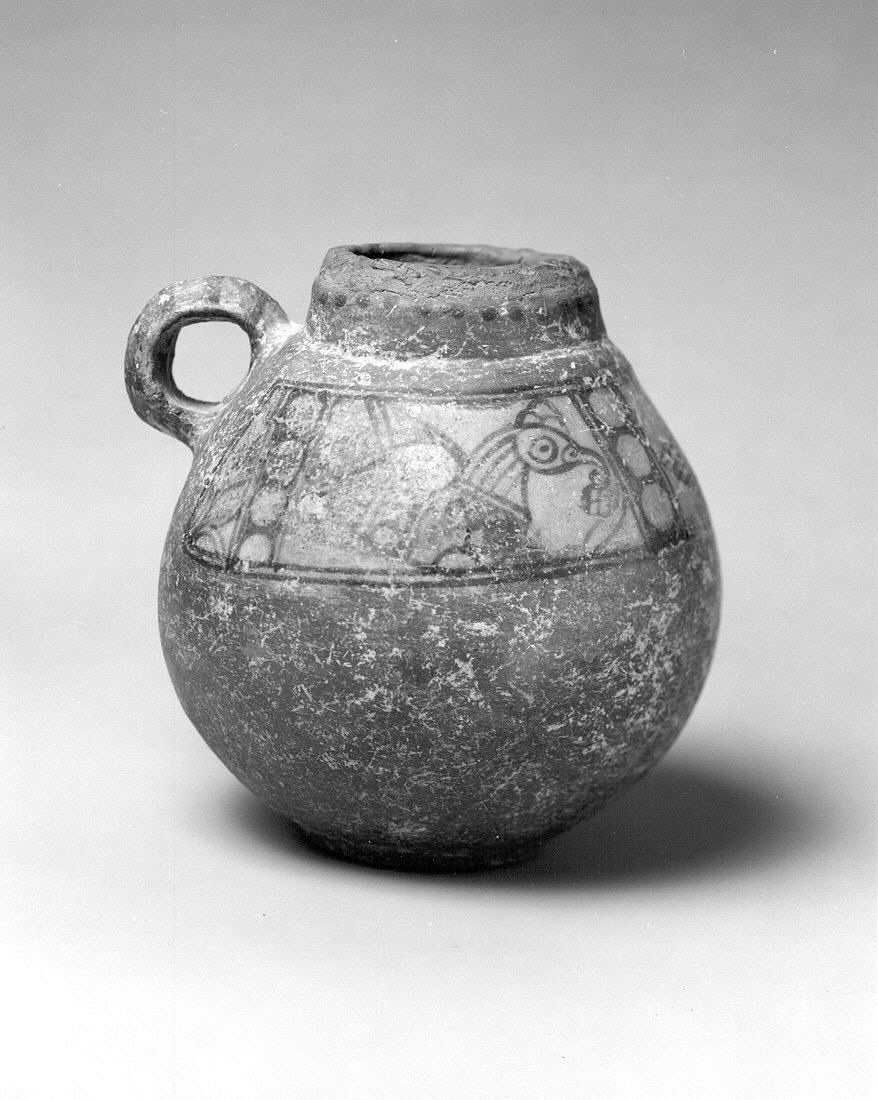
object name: vessel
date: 1-1000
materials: ceramic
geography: central asia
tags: birds